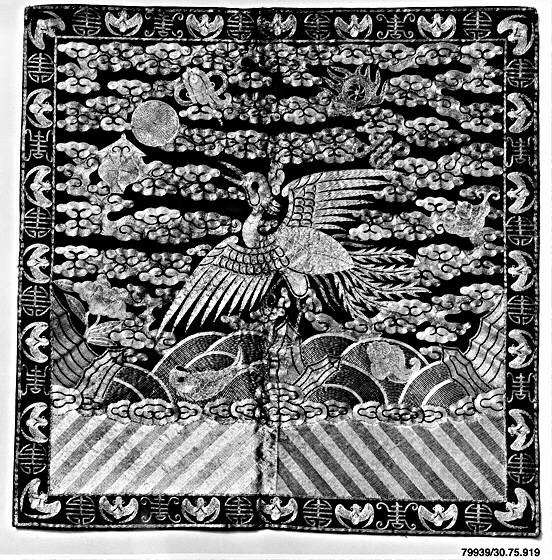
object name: rank badge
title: Rank Badge with Silver Pheasant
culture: chinese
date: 1767-1833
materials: metal thread, silk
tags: bats,pheasants,fish